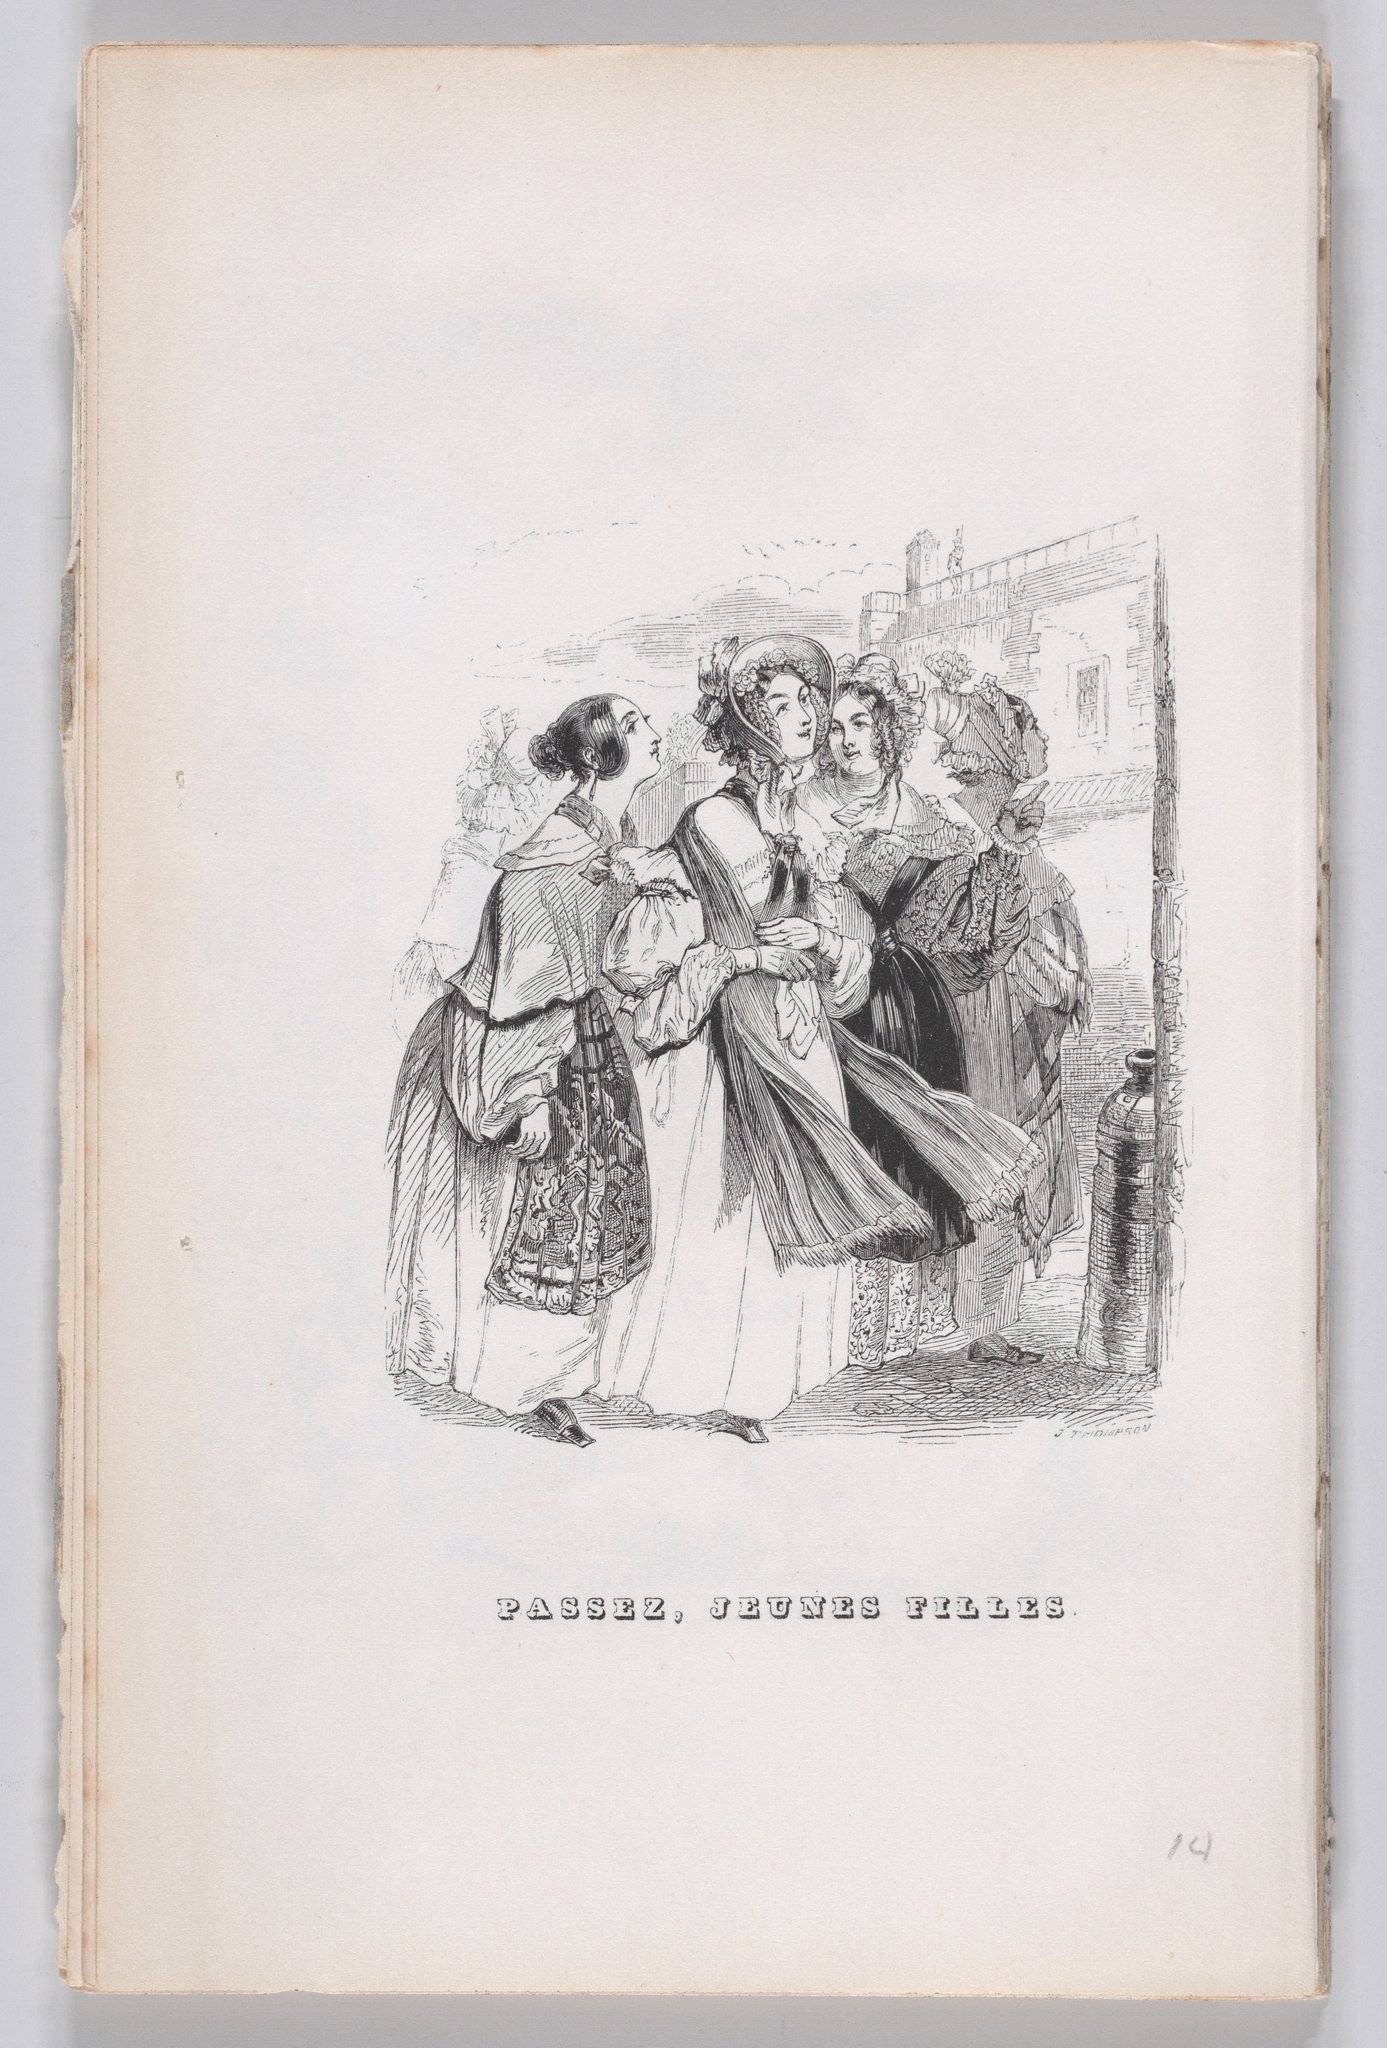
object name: print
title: Passing Young Girls, from "The Complete Works of Béranger"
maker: j. j. grandville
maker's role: illustrator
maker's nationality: french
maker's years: 1803-1847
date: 1836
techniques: engraving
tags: women